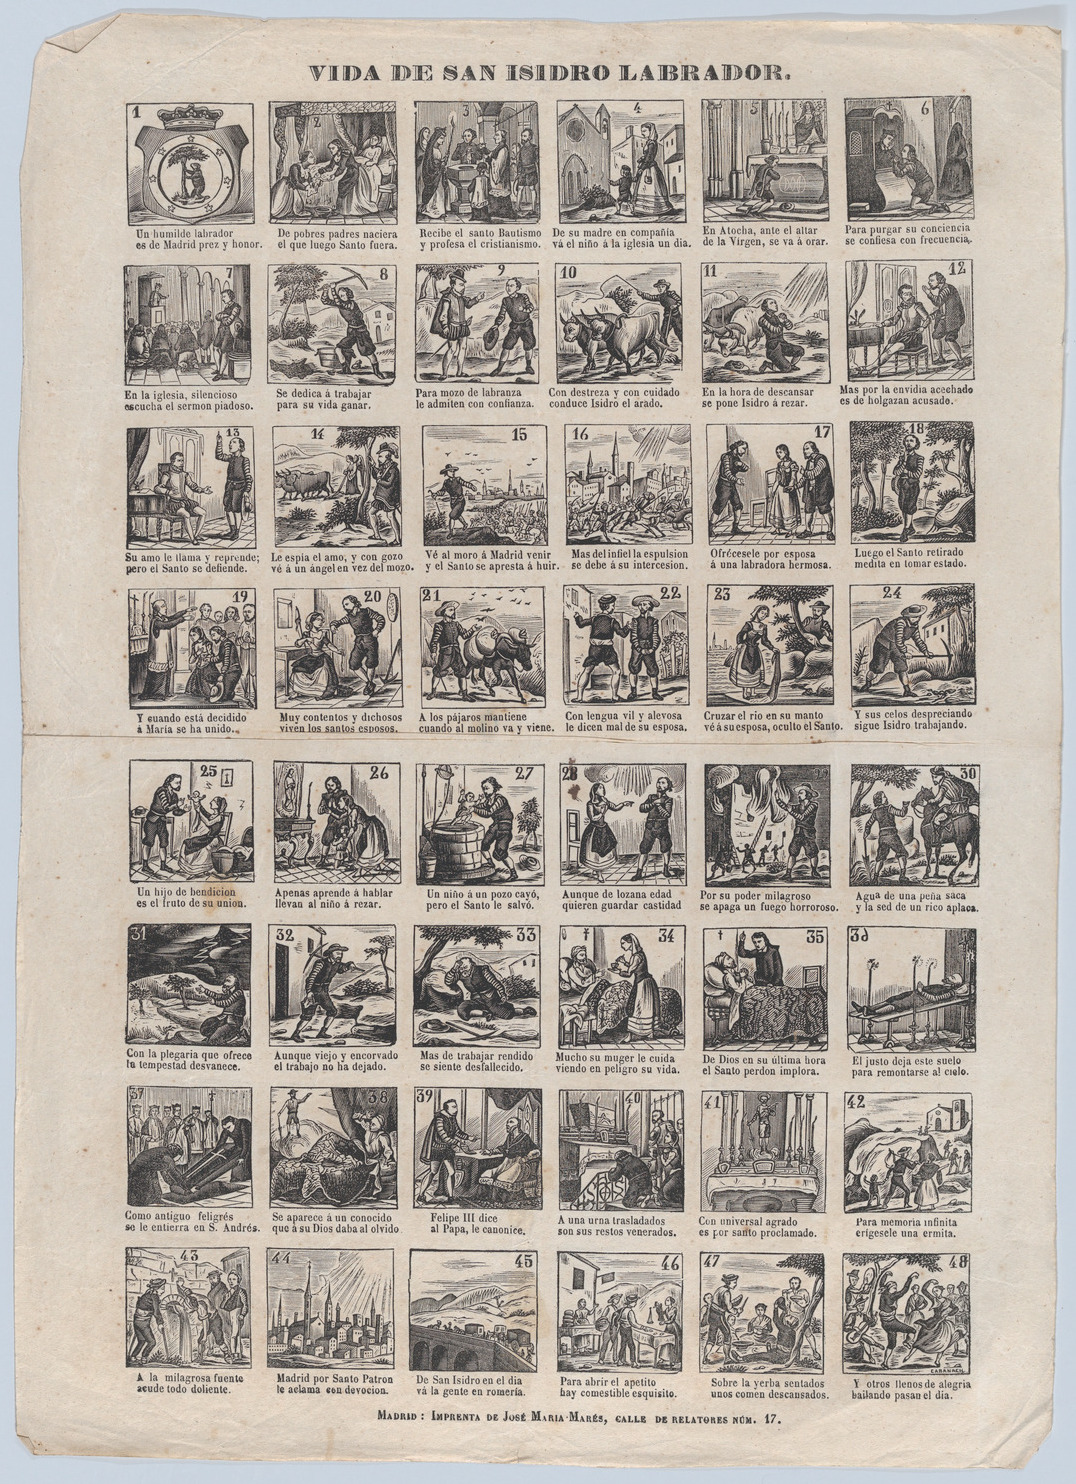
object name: print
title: Broadside with 48 scenes from the life of San Isidro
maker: josé maría marés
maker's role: publisher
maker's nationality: spanish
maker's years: 1850-1870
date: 1860-1870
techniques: engraving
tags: men,women,cows,horses